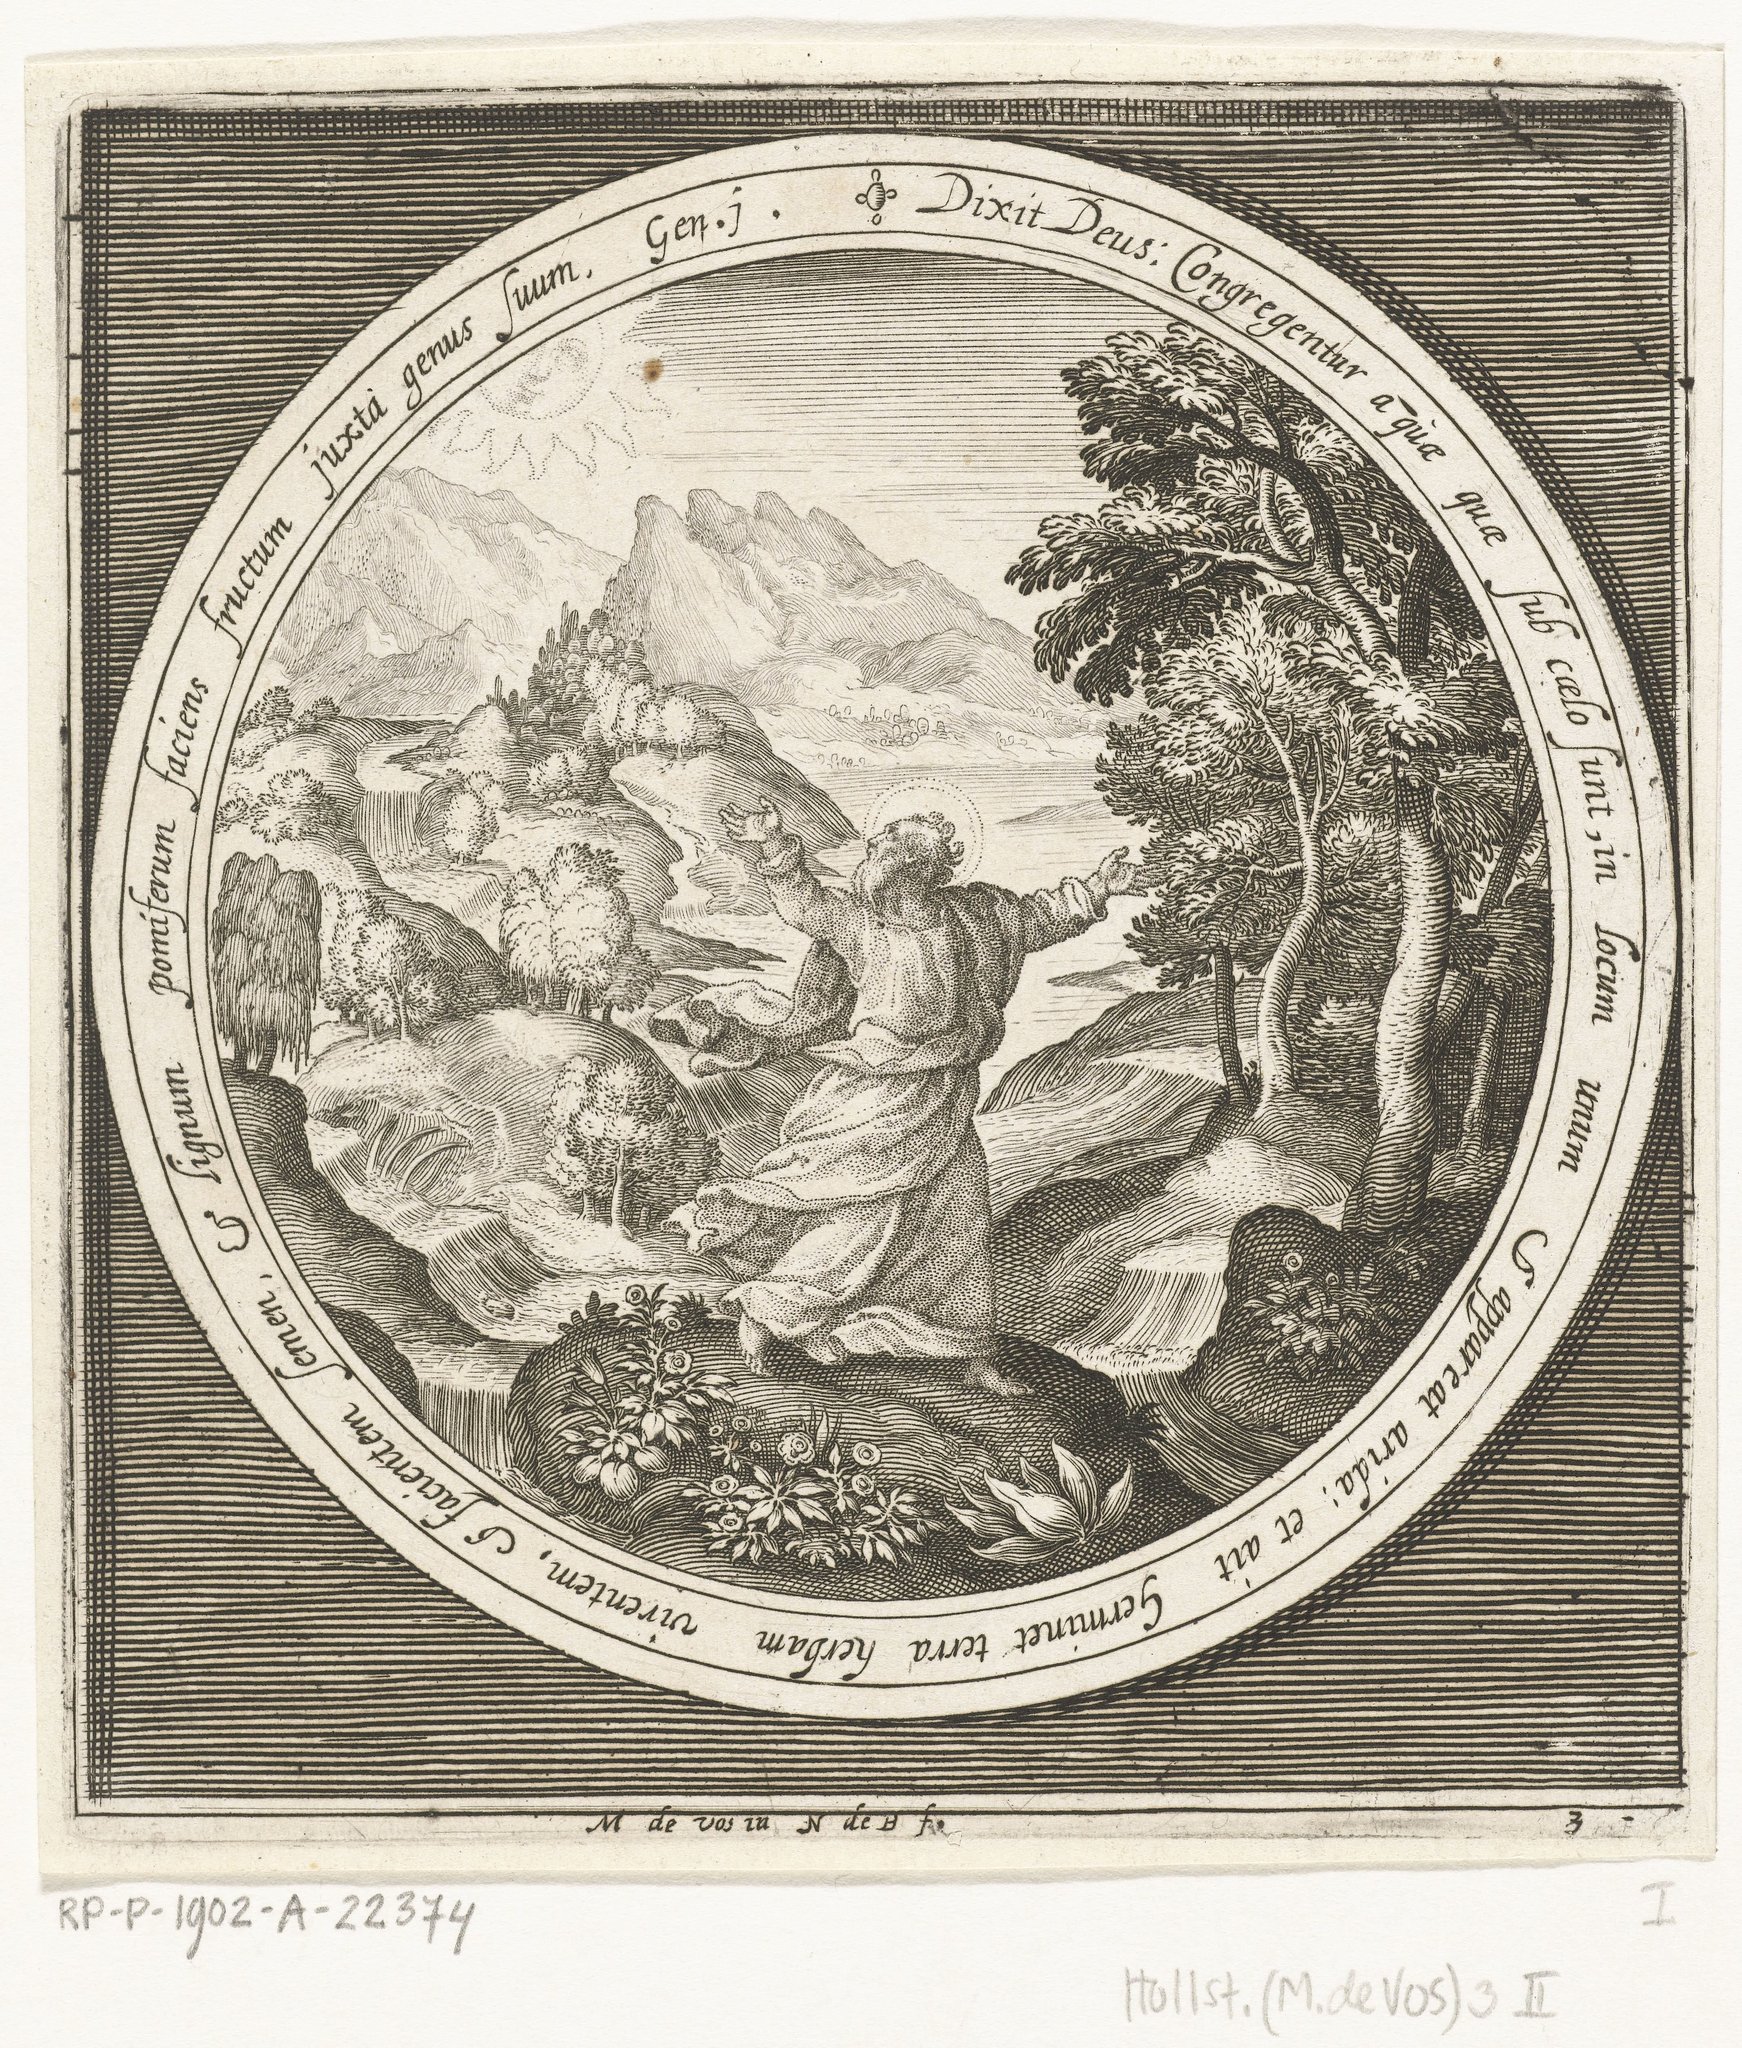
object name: print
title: Derde dag van schepping: God schept land en zaadvormende planten en bomen met vruchten die zaden dragen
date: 1581-1656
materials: paper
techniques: engraving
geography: netherlands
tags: gathering of the waters below the firmament; dry land appears and produces all kinds of plants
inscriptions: collector's mark: Lugt 2542, collector's mark: Lugt 2228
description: Derde dag van schepping: God schept land en zaadvormende planten en bomen met vruchten die zaden dragen. Het water trekt zich terug in rivieren en de zee. In medaillon met als opschrift een bijbeltekst in Latijn uit Genesis 1, binnen rechthoekige omlijsting.